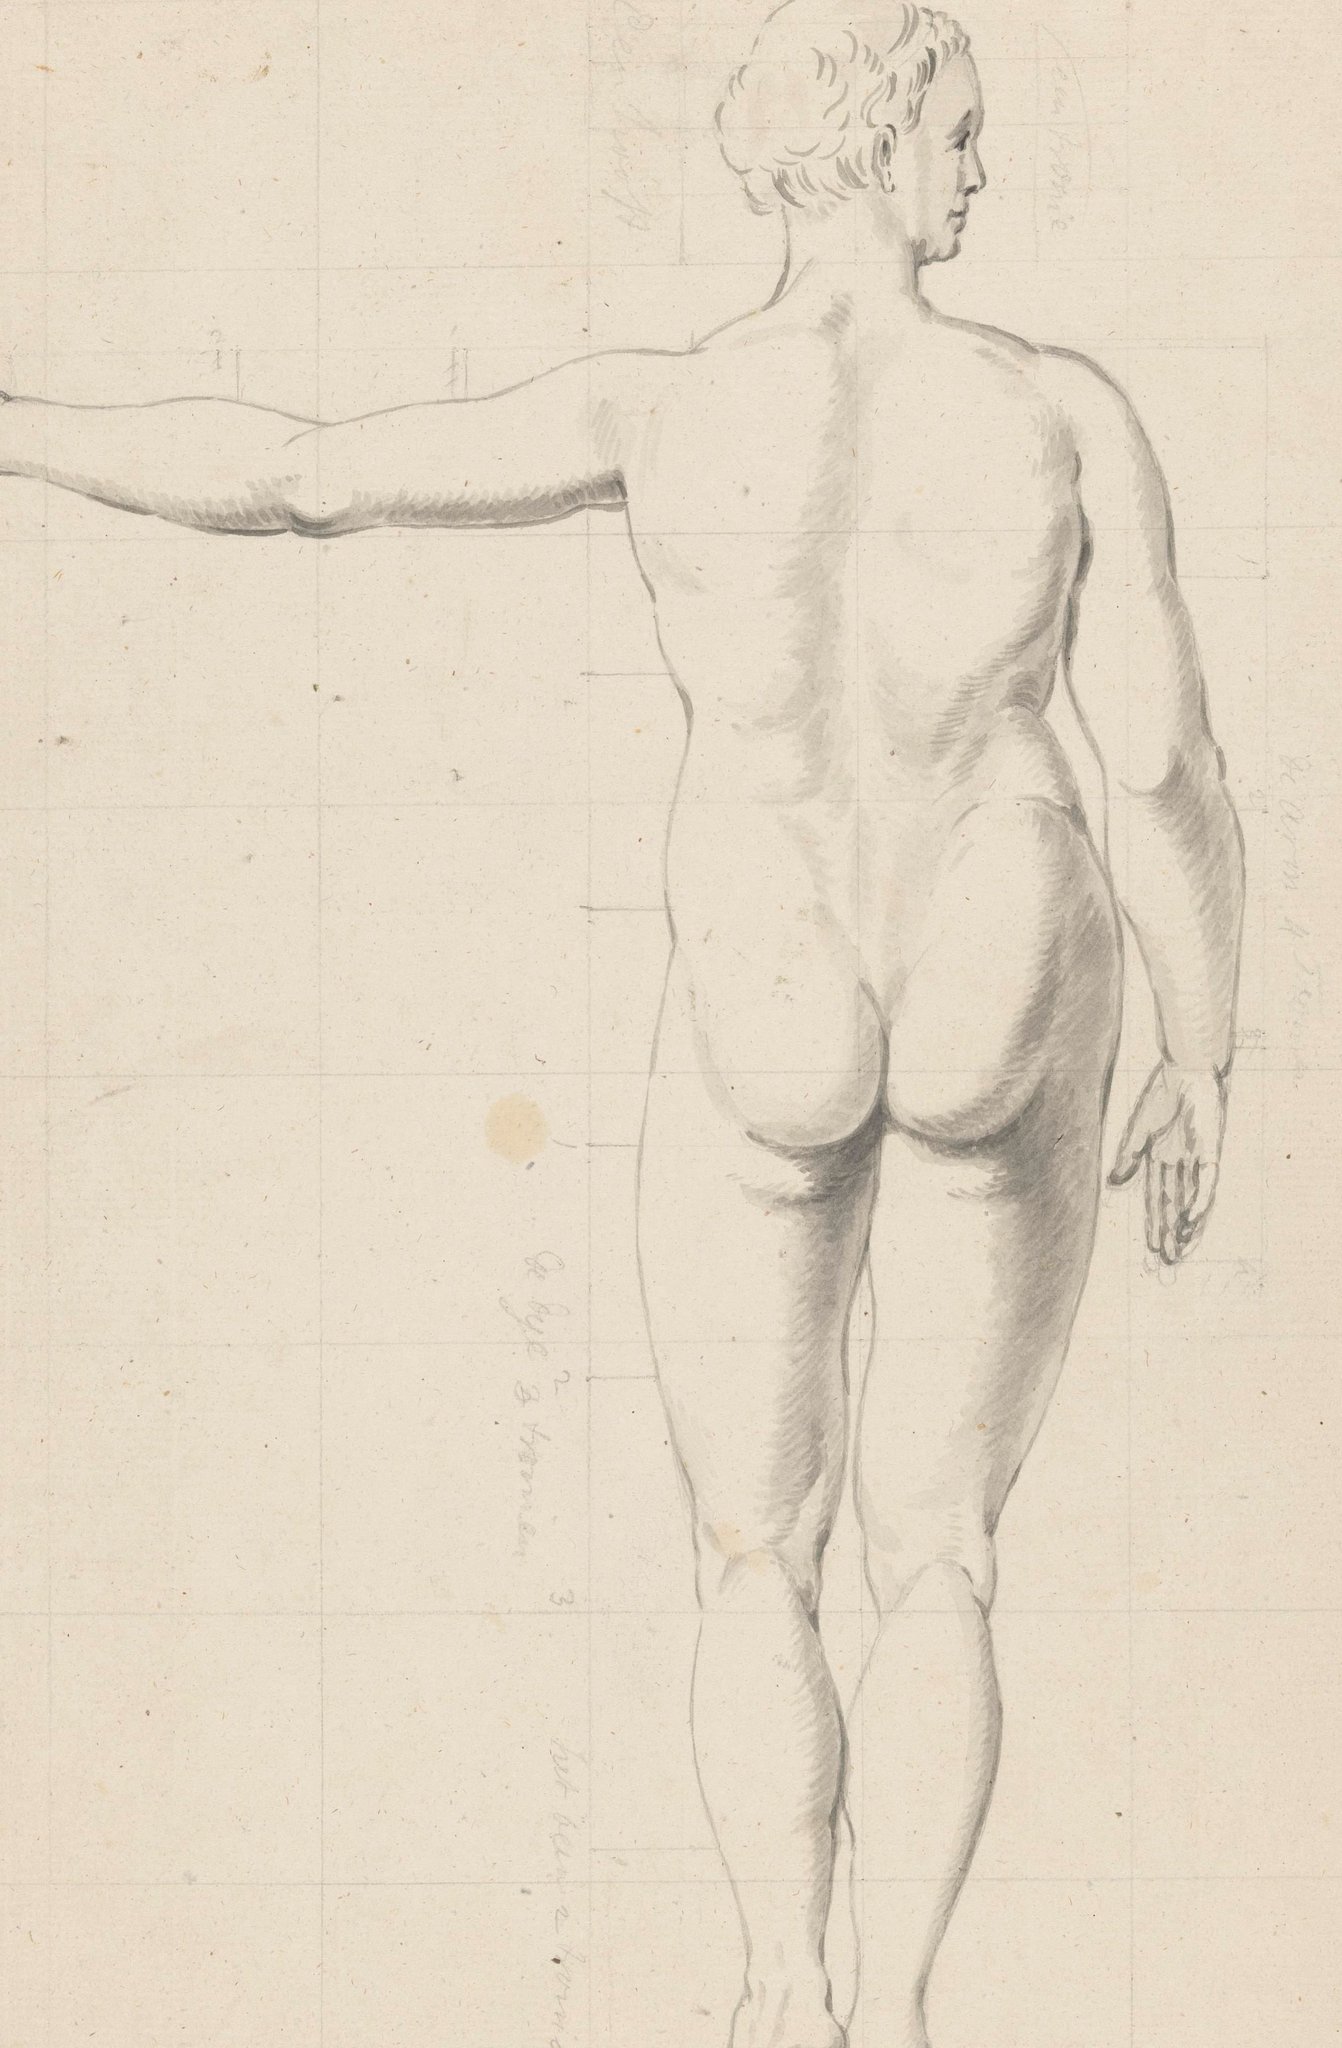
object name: drawing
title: Naaktstudies van vrouw en man, op de rug gezien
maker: jan brandes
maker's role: draughtsman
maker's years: 1743-1808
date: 1787-1808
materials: paper, pencil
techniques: brush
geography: skälsebo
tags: standing figure, standing figure (canon, proportions) - aa - female human figure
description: Dubbelgevouwen blad met schematische figuurstudies van staande naakte vrouw en man, op de rug gezien. Met allerlei verhoudingen en afmetingen. Gekopieerd uit een voorbeeldboek.